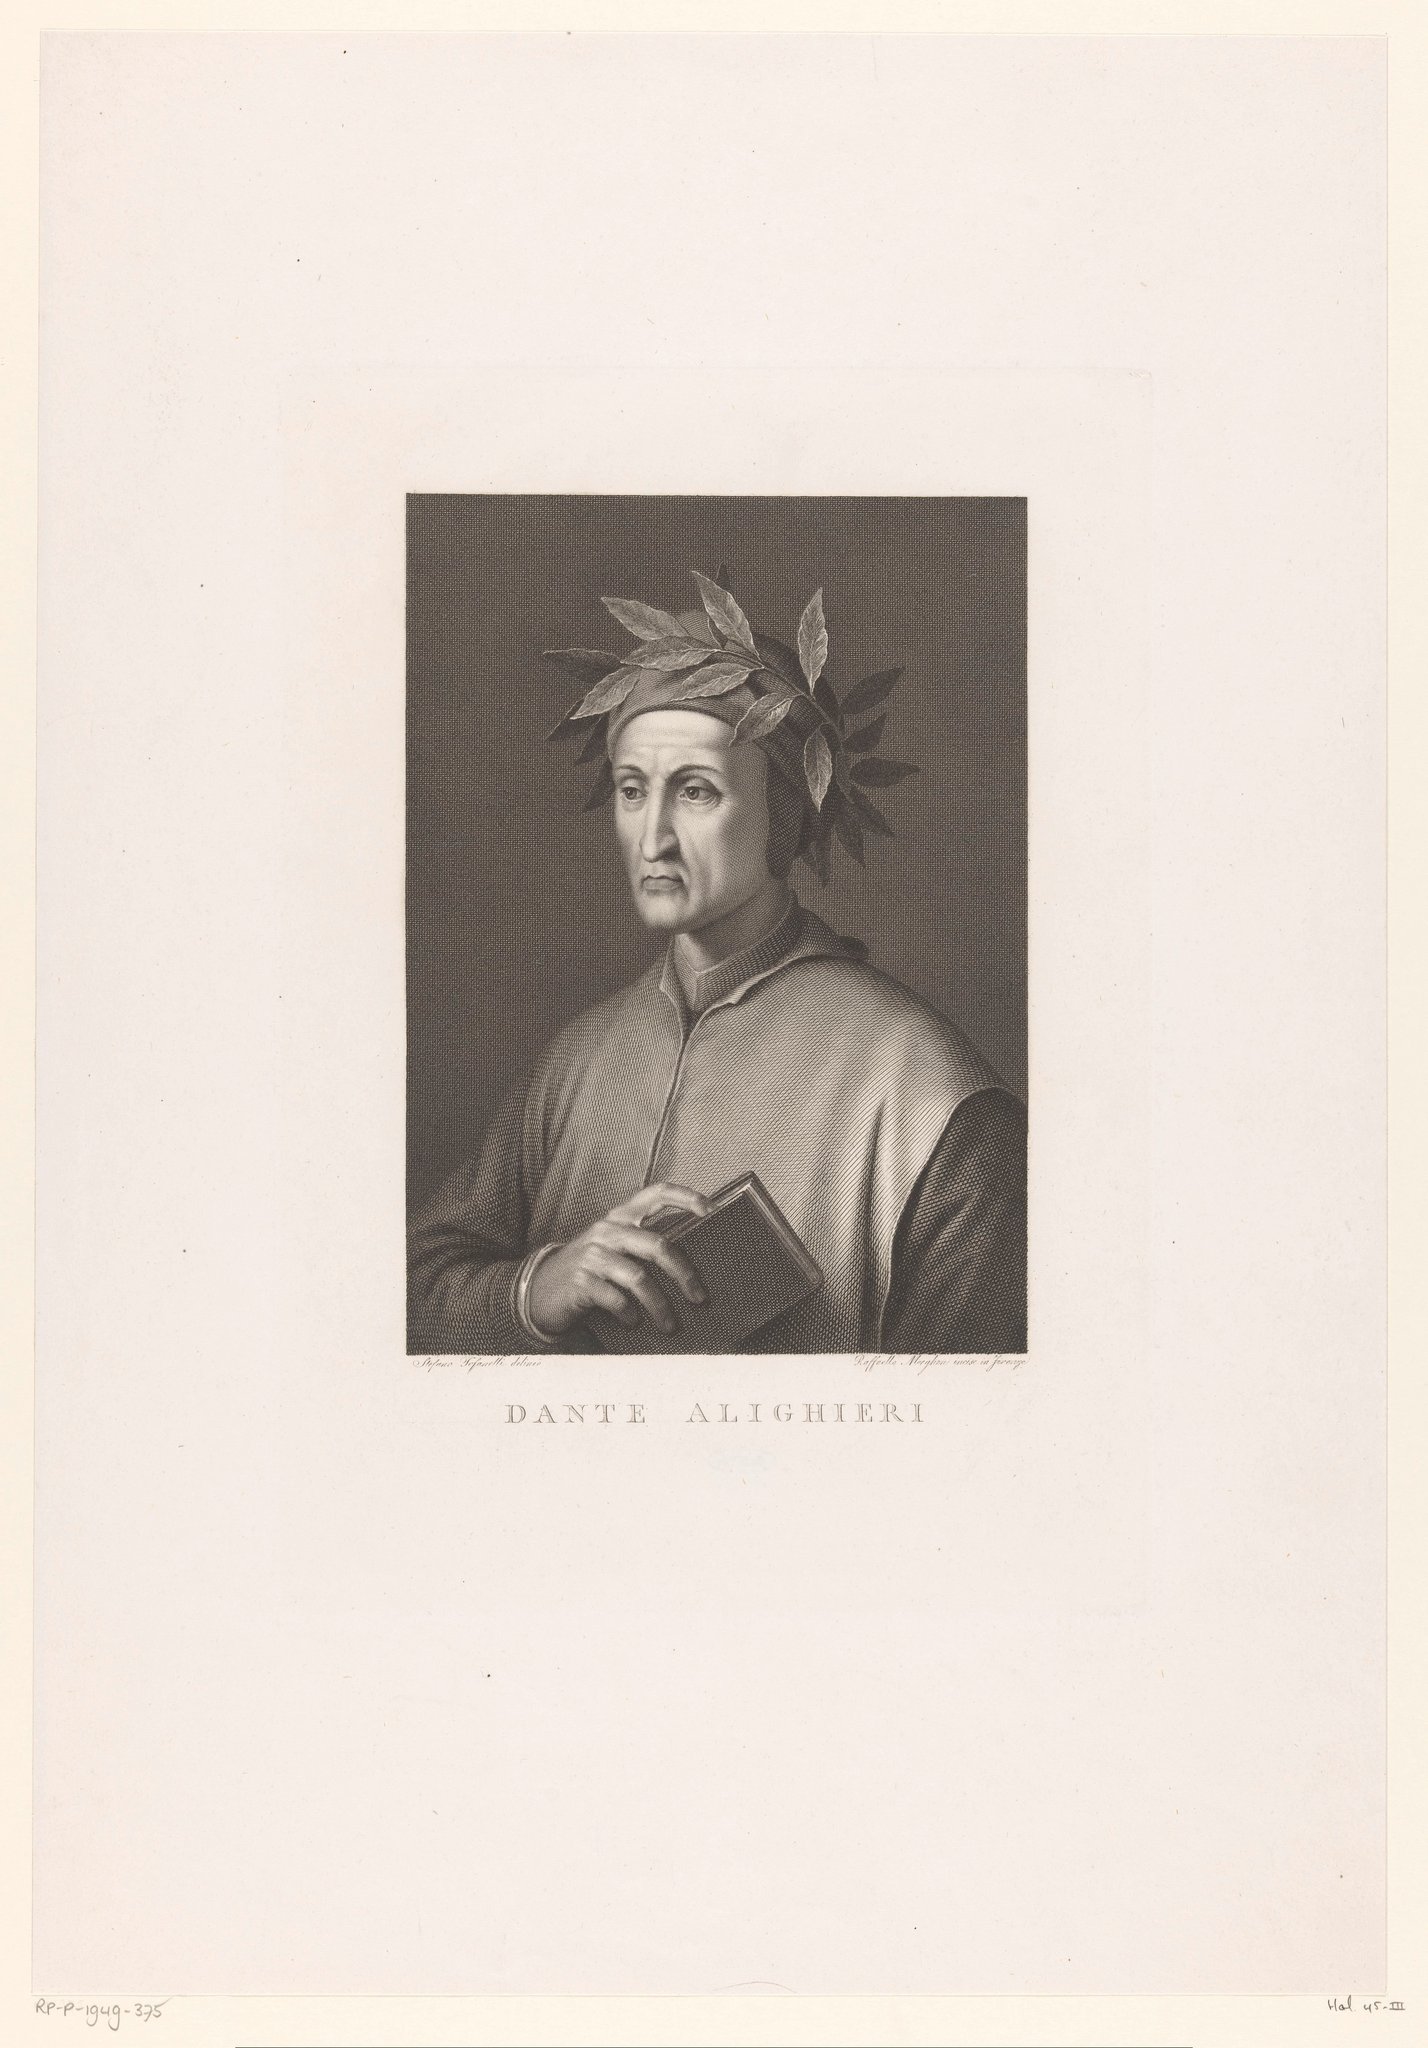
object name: print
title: Portret van dichter Dante Alighieri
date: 1768-1833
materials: paper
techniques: engraving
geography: italy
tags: dante alighieri, historical persons, portrait of a writer, writer, poet, author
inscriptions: collector's mark: Lugt 2228